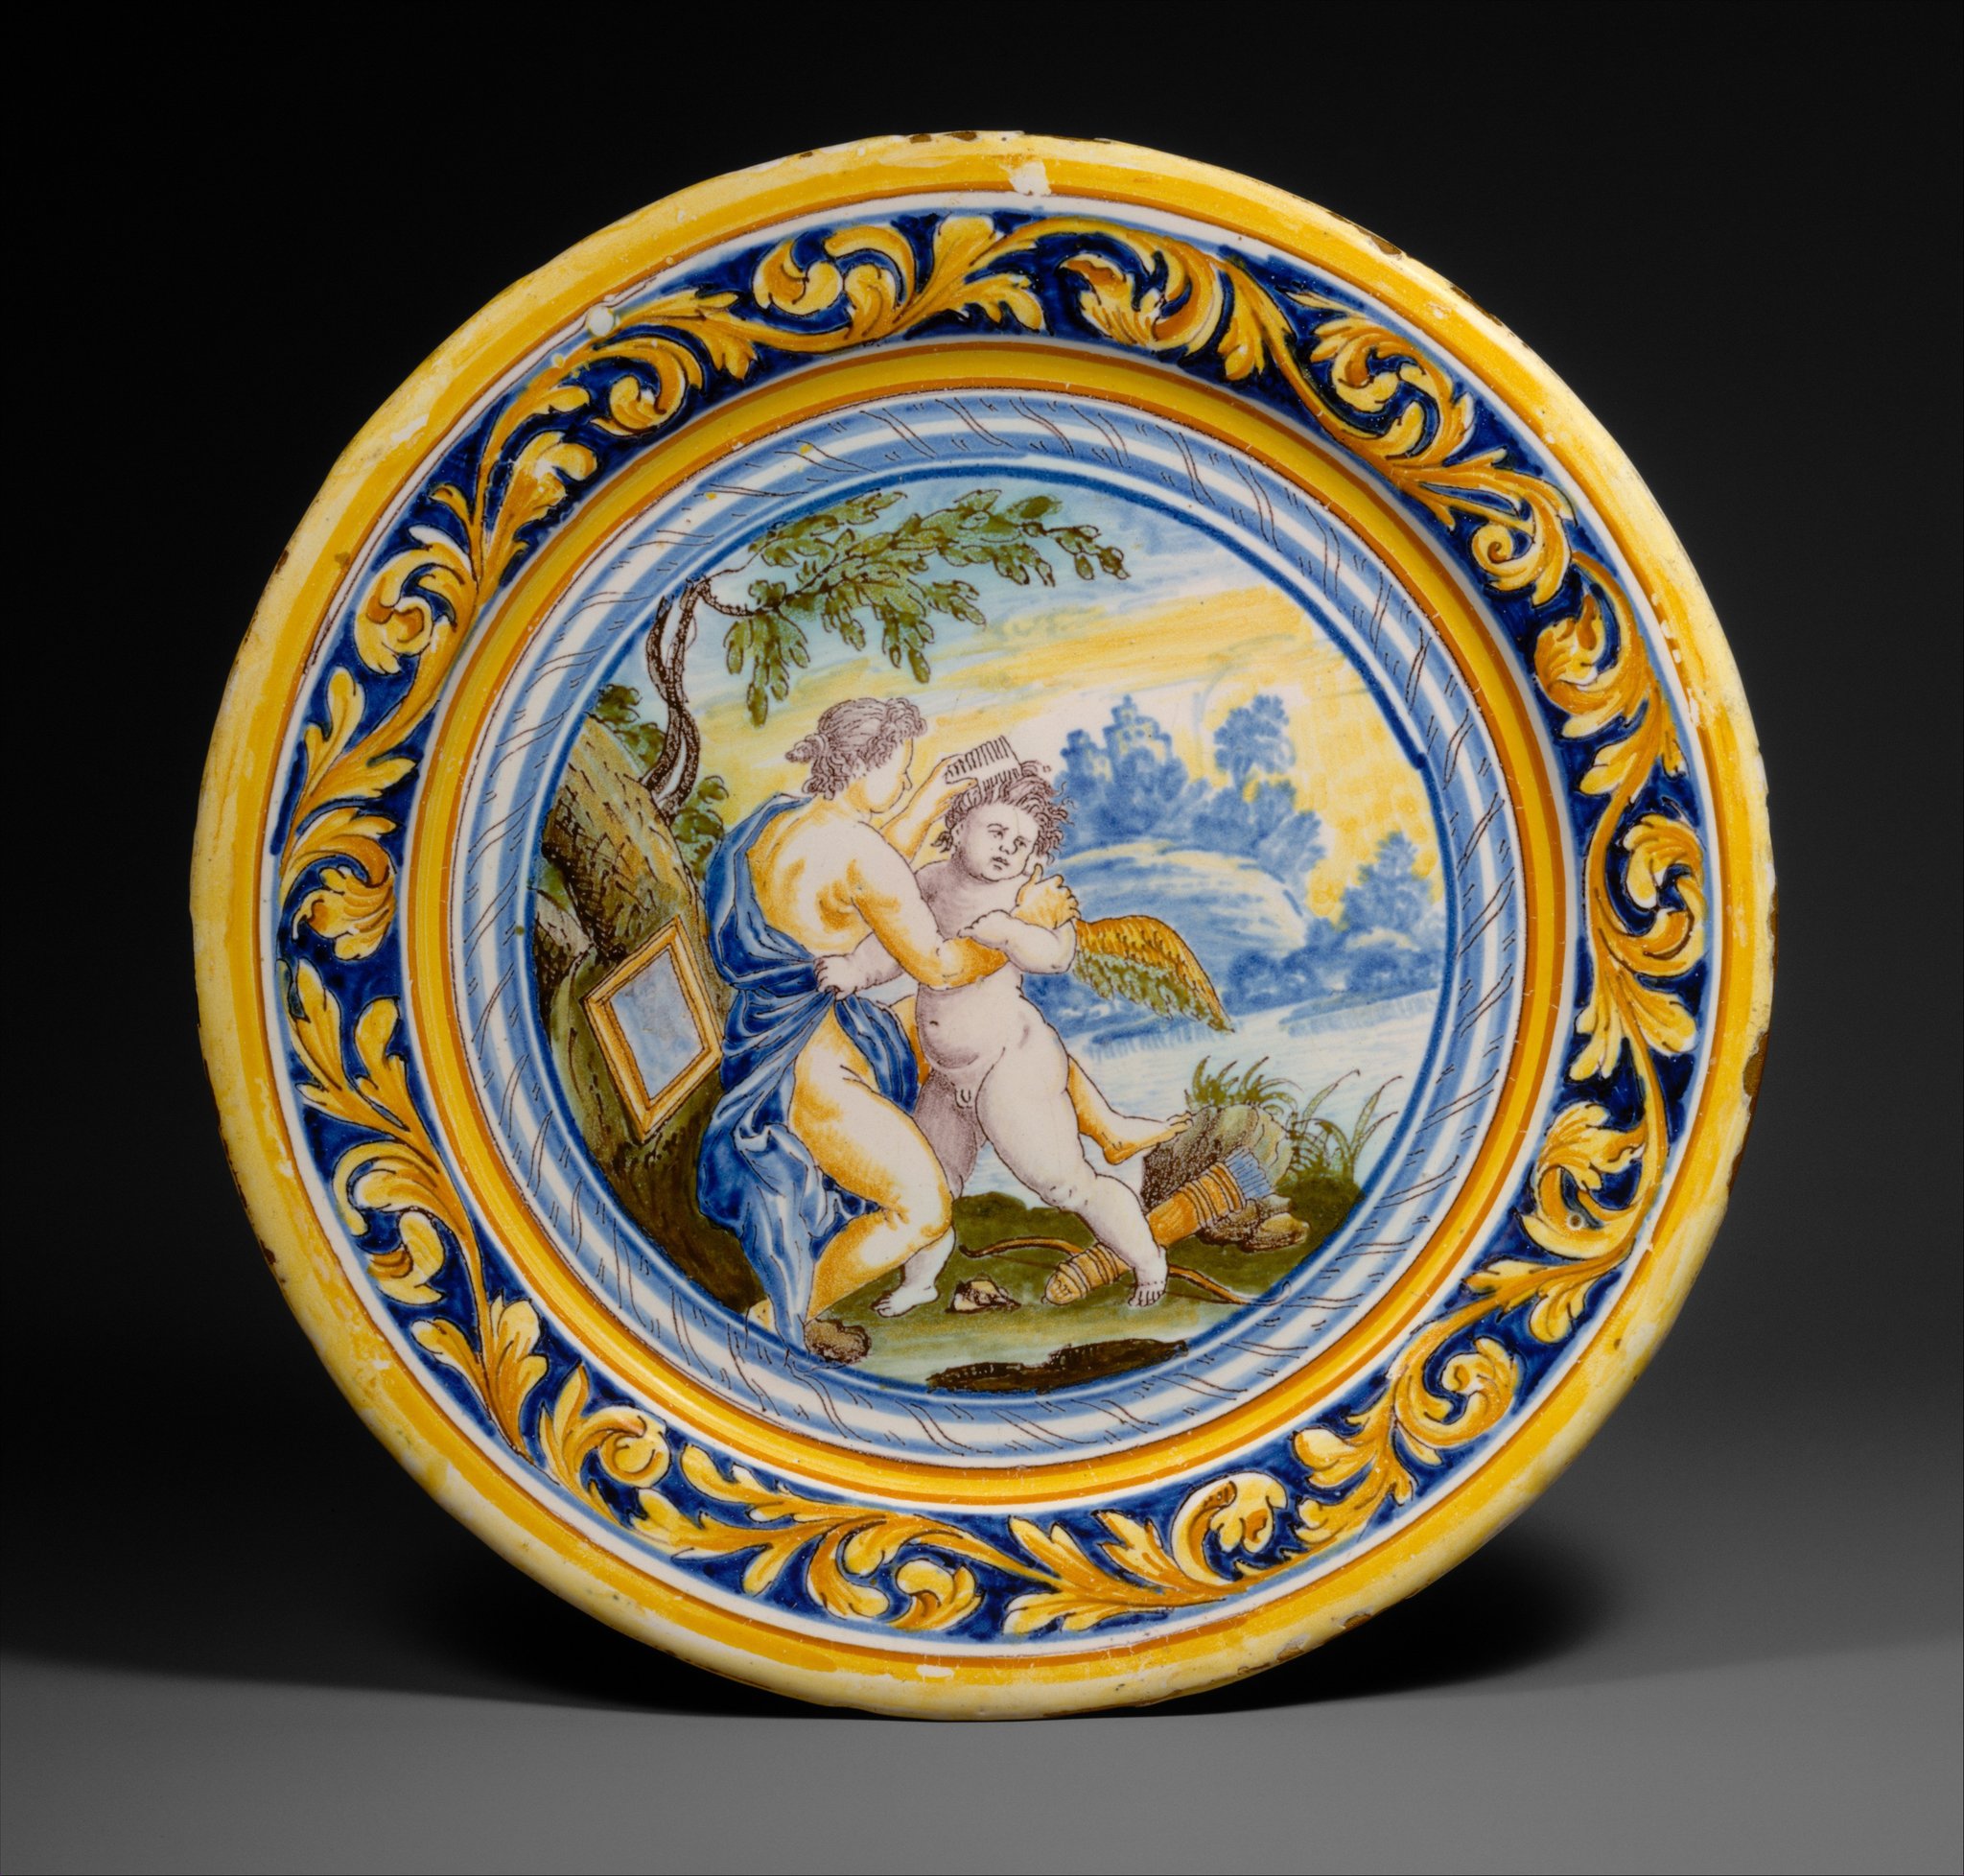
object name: plate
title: Plate with Venus combing Cupid's hair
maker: odoardo fialetti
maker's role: artist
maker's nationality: italian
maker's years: 1573-1638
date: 1634-1666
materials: faience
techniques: glazing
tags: bow and arrow,cupid,venus